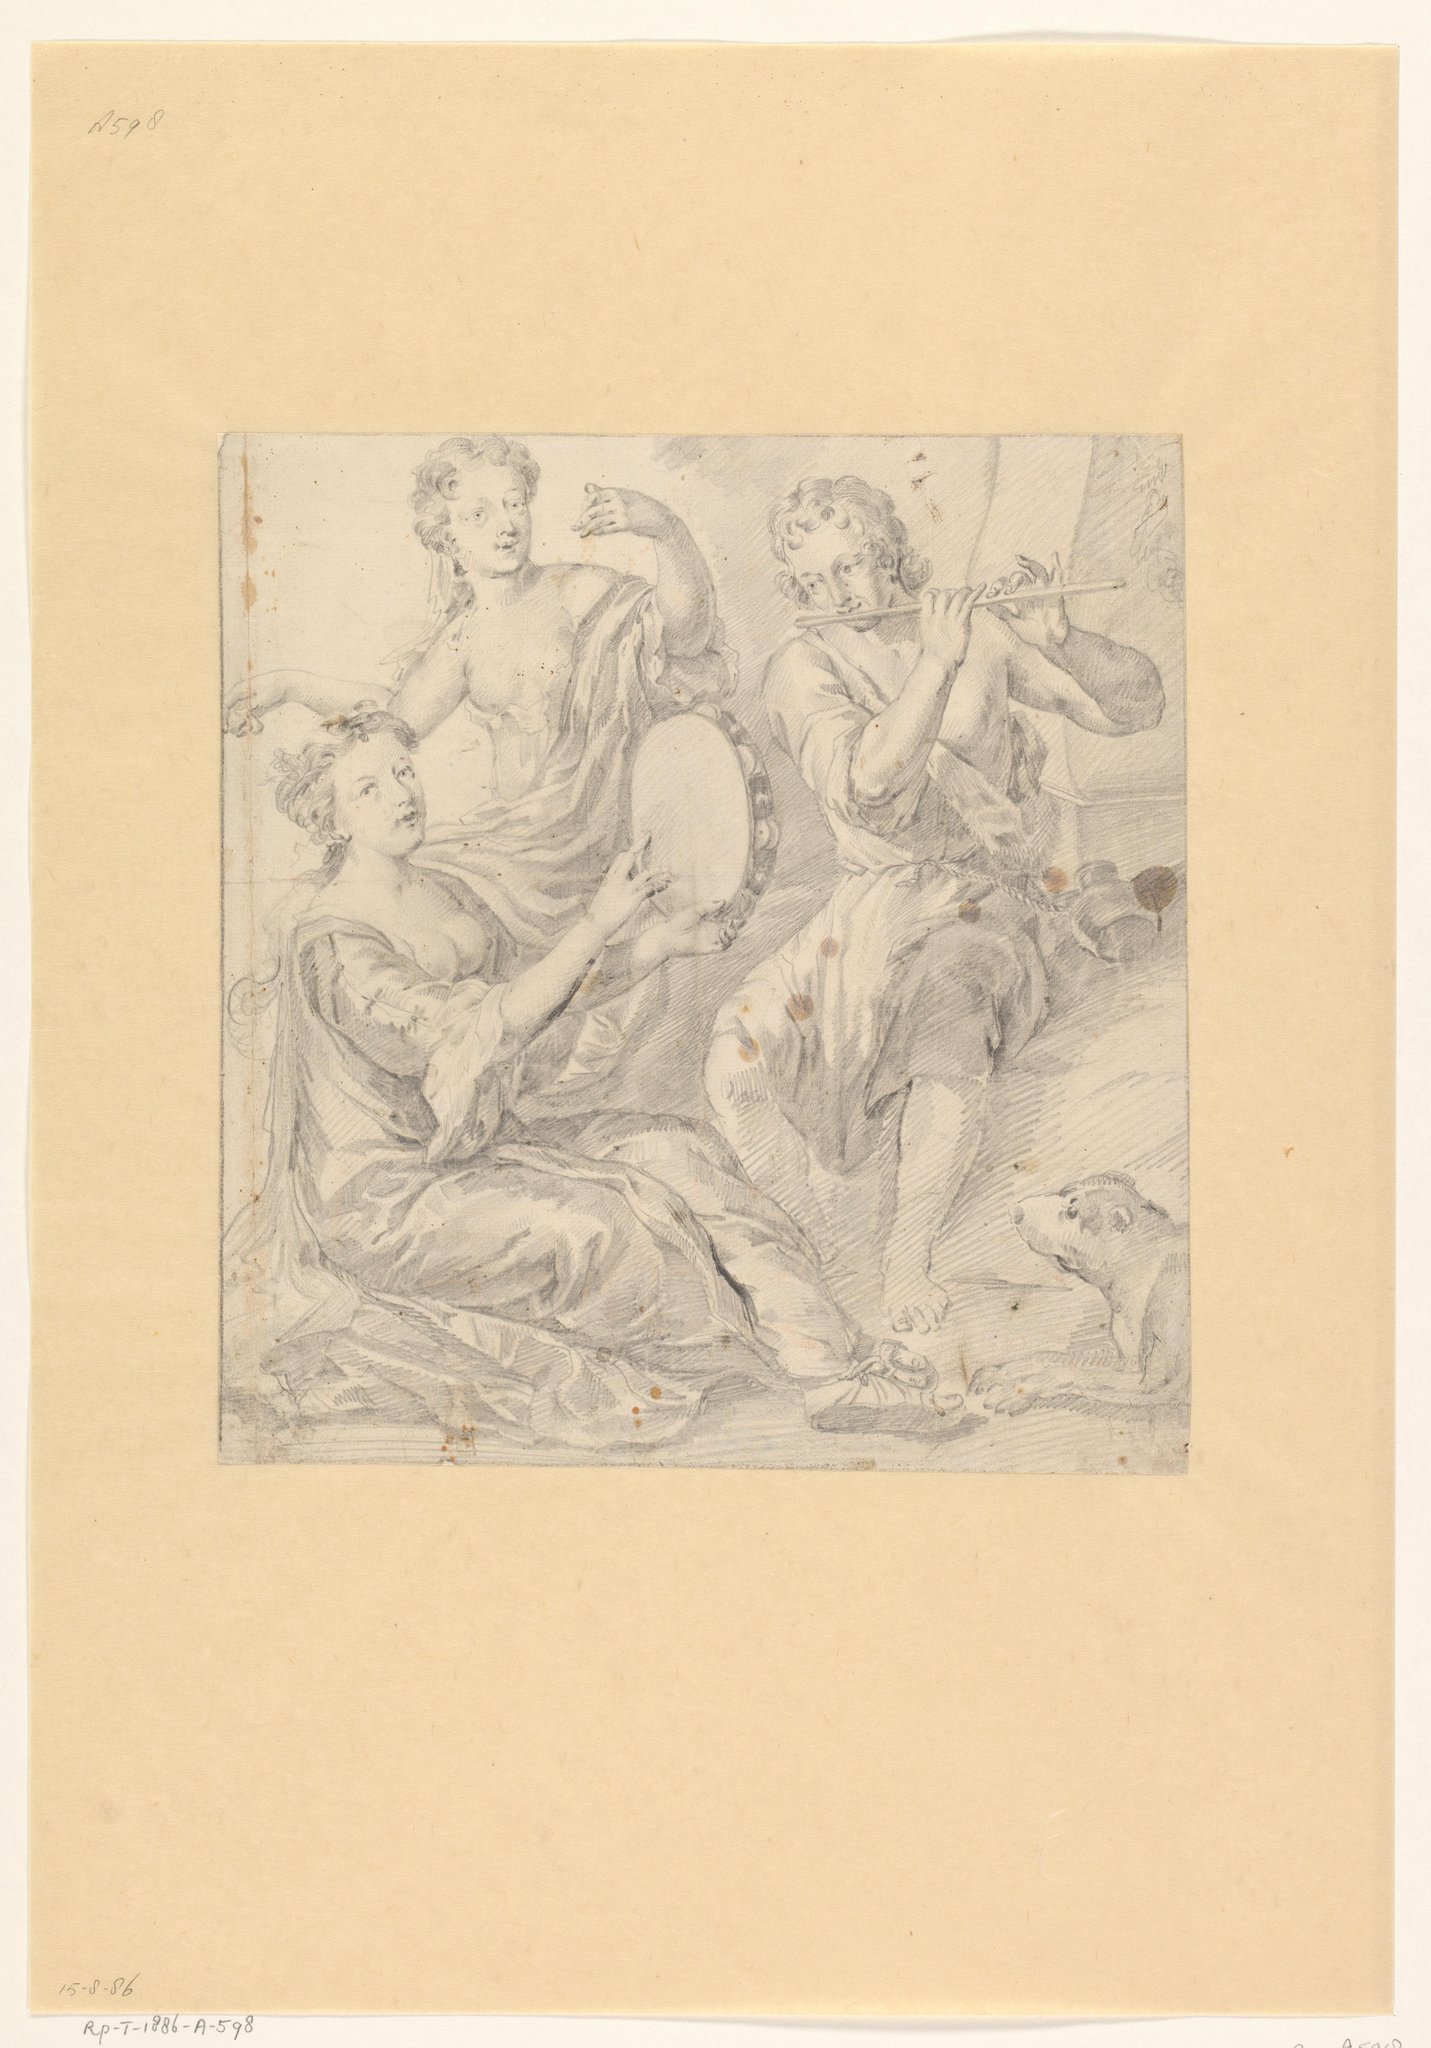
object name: drawing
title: Muziekgezelschap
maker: gerard hoet (i)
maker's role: draughtsman, painter, print maker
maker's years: 1648-1733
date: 1658-1733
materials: paper, pencil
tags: tambourine, clappers, castanets, flute, aulos, tibia, more than one musician with instrument